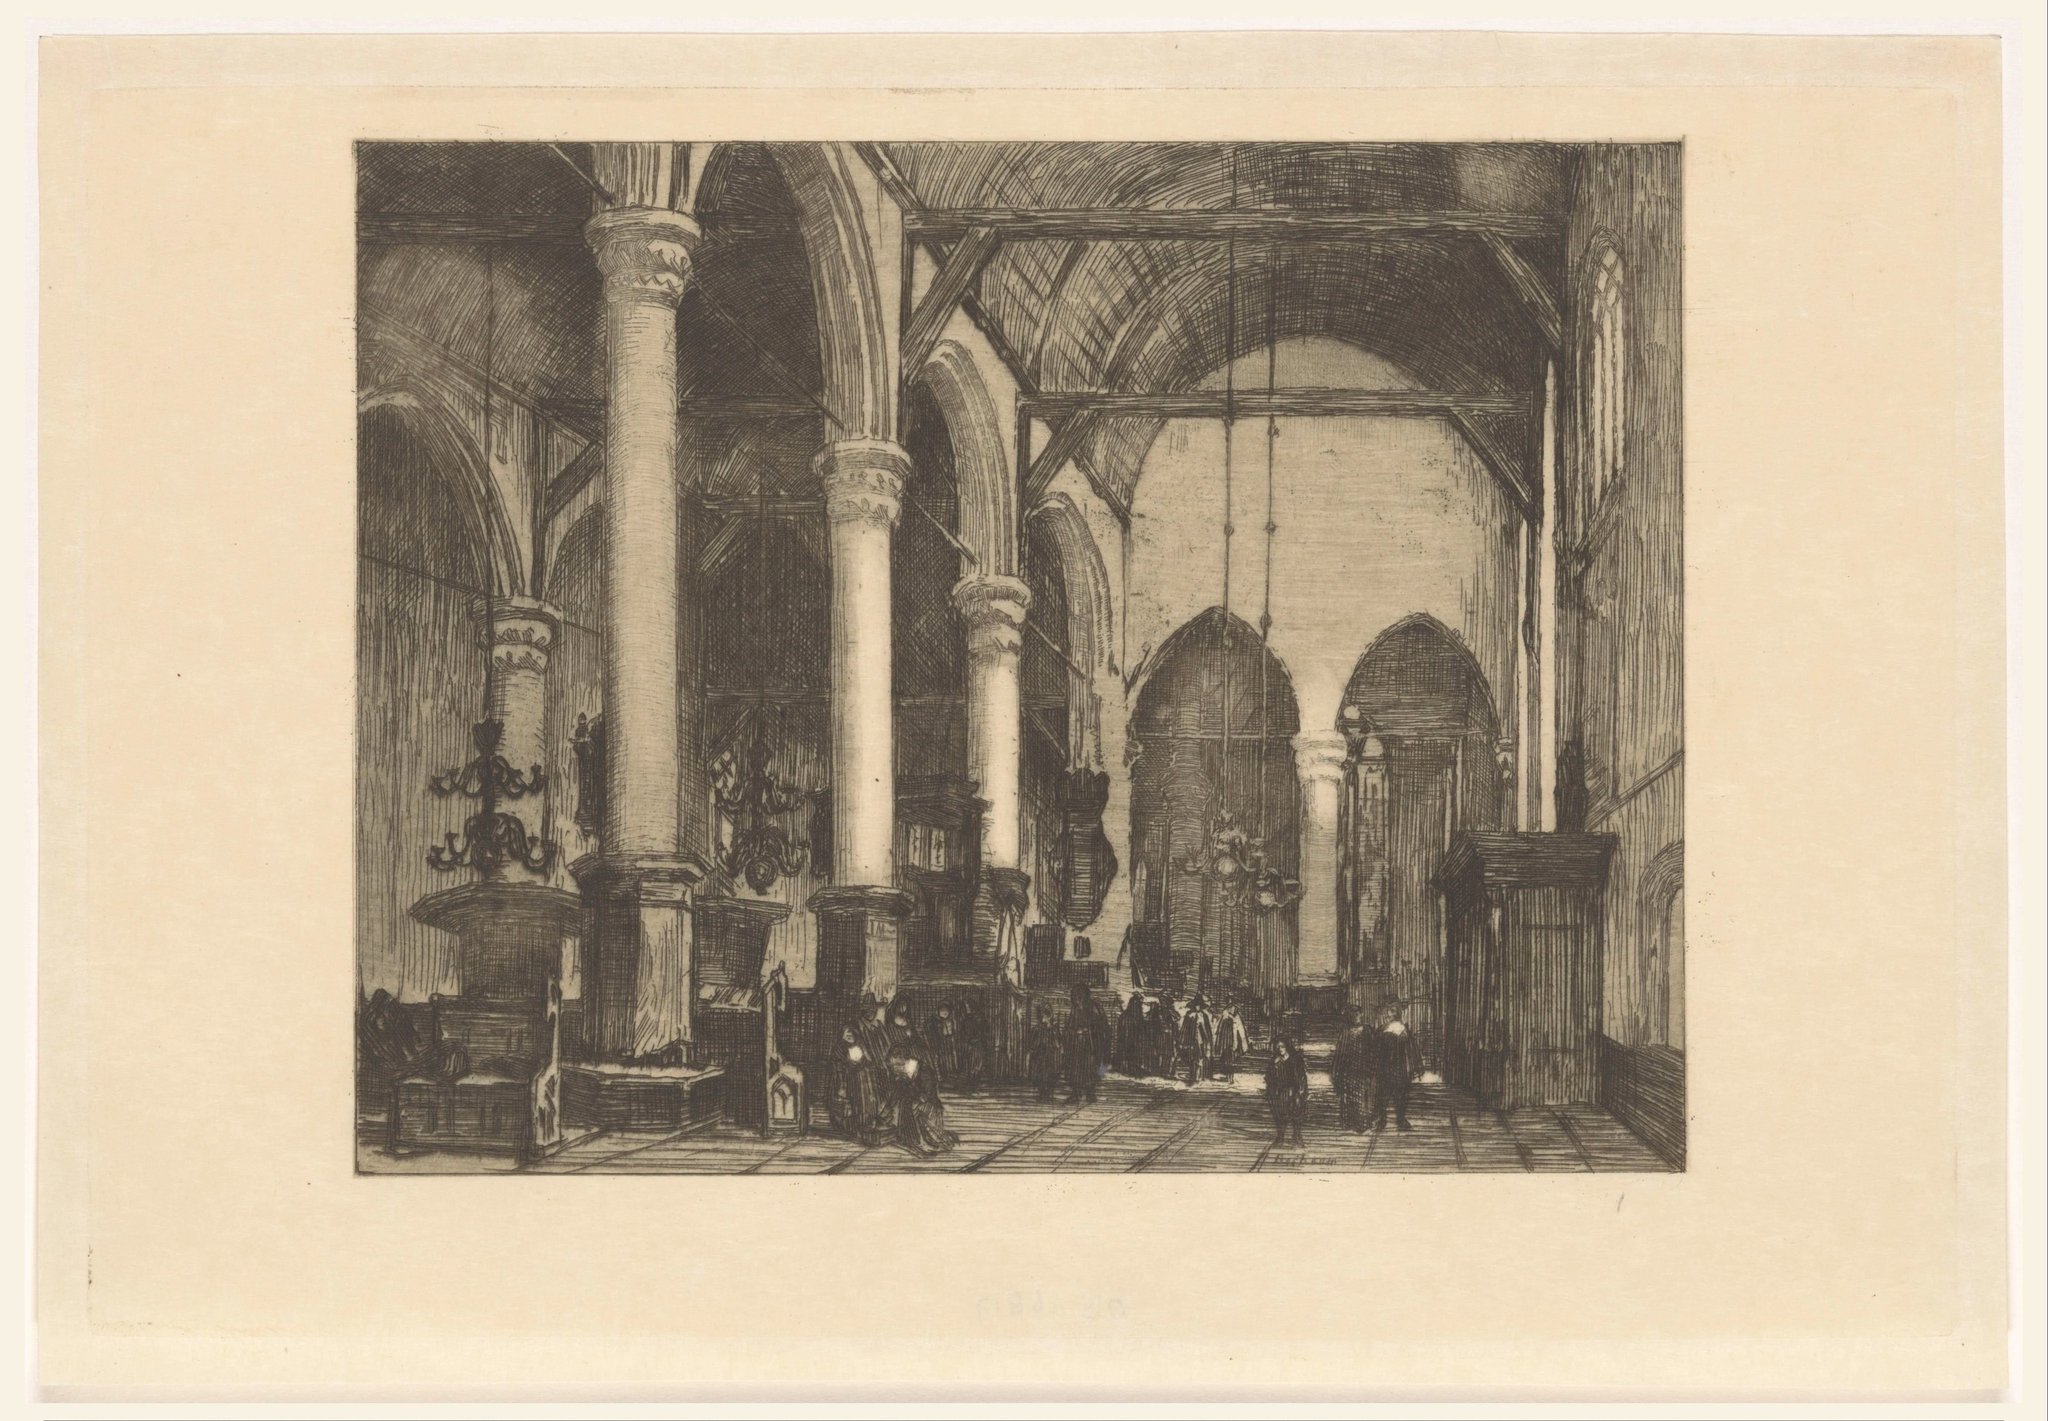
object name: print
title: De Groote Kerk te Edam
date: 1878-1931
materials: paper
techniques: etching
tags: interior of church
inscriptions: collector's mark: Lugt 2228